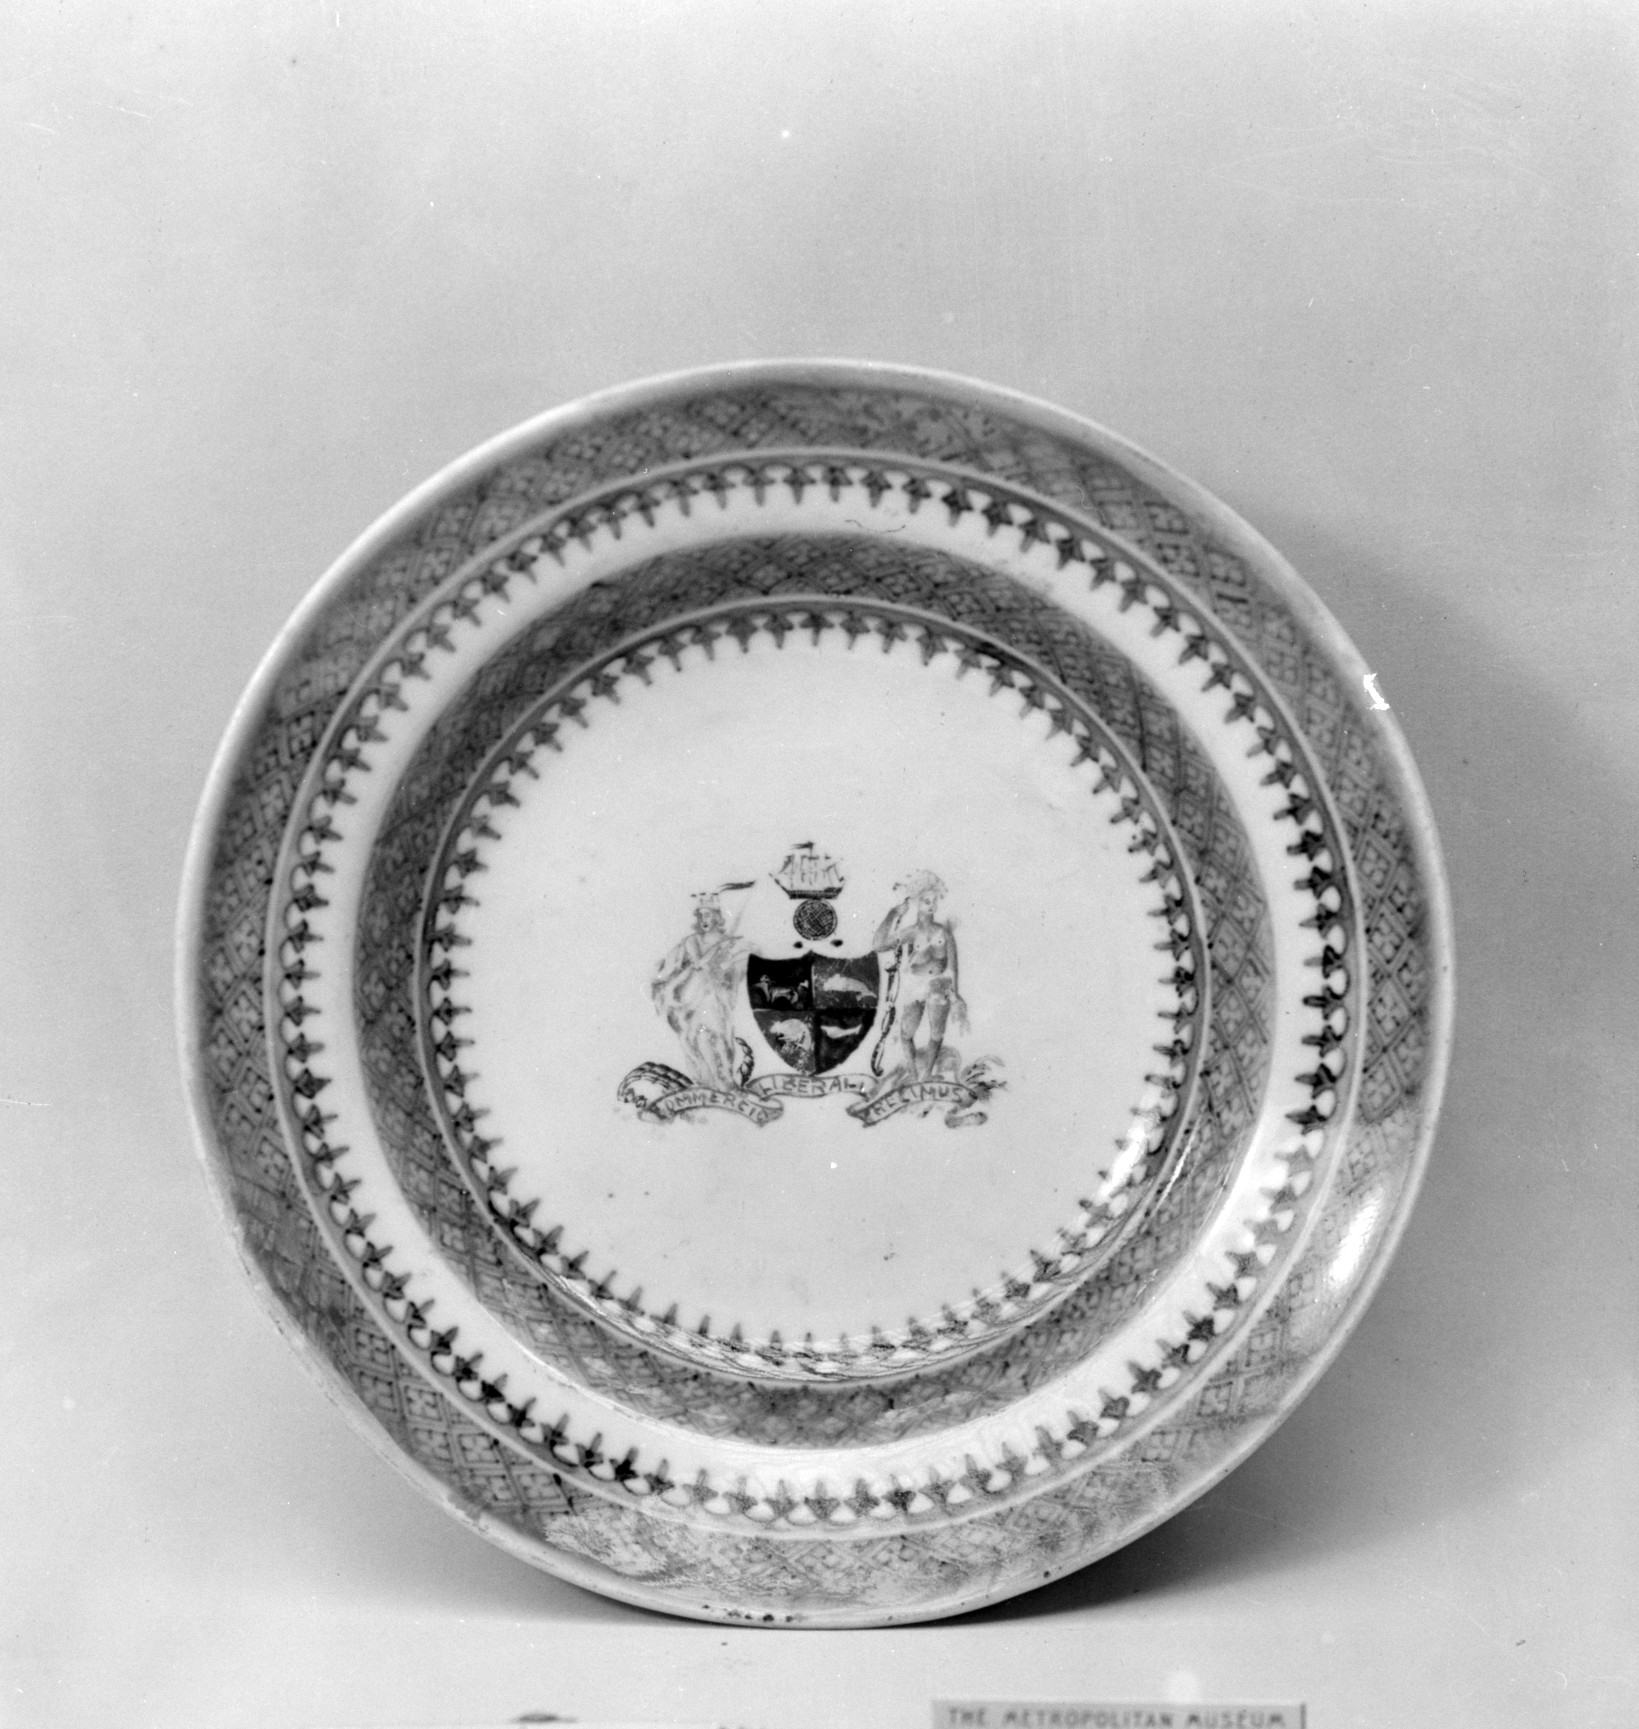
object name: dish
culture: chinese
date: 1780-1790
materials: porcelain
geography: china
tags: coat of arms